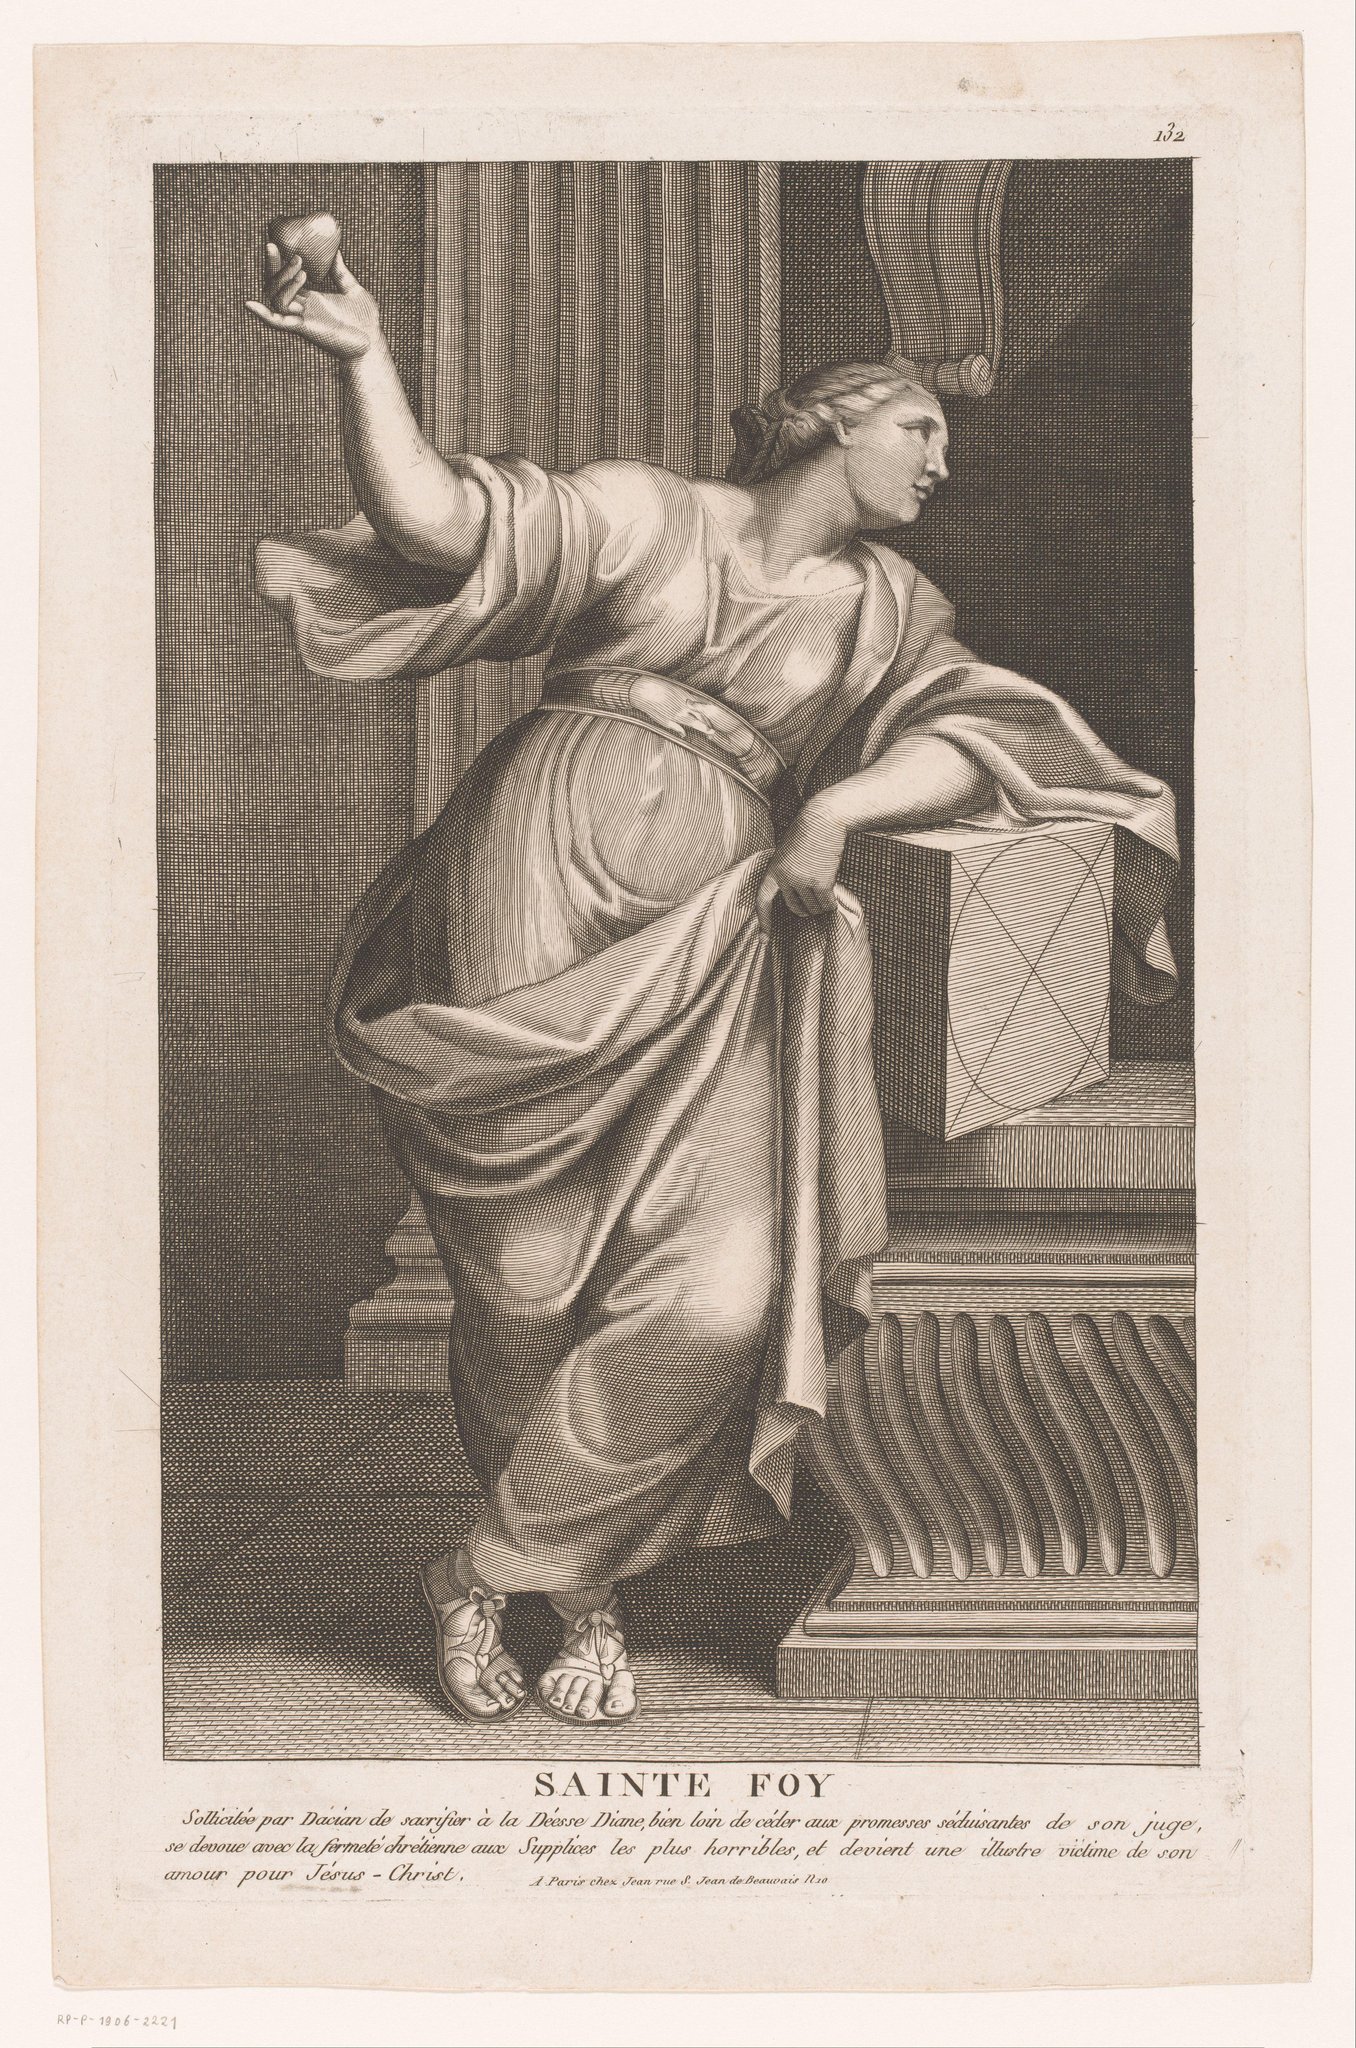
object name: print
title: Sainte Foy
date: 1690-1730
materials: paper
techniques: engraving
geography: paris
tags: female saints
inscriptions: collector's mark: Lugt 2228